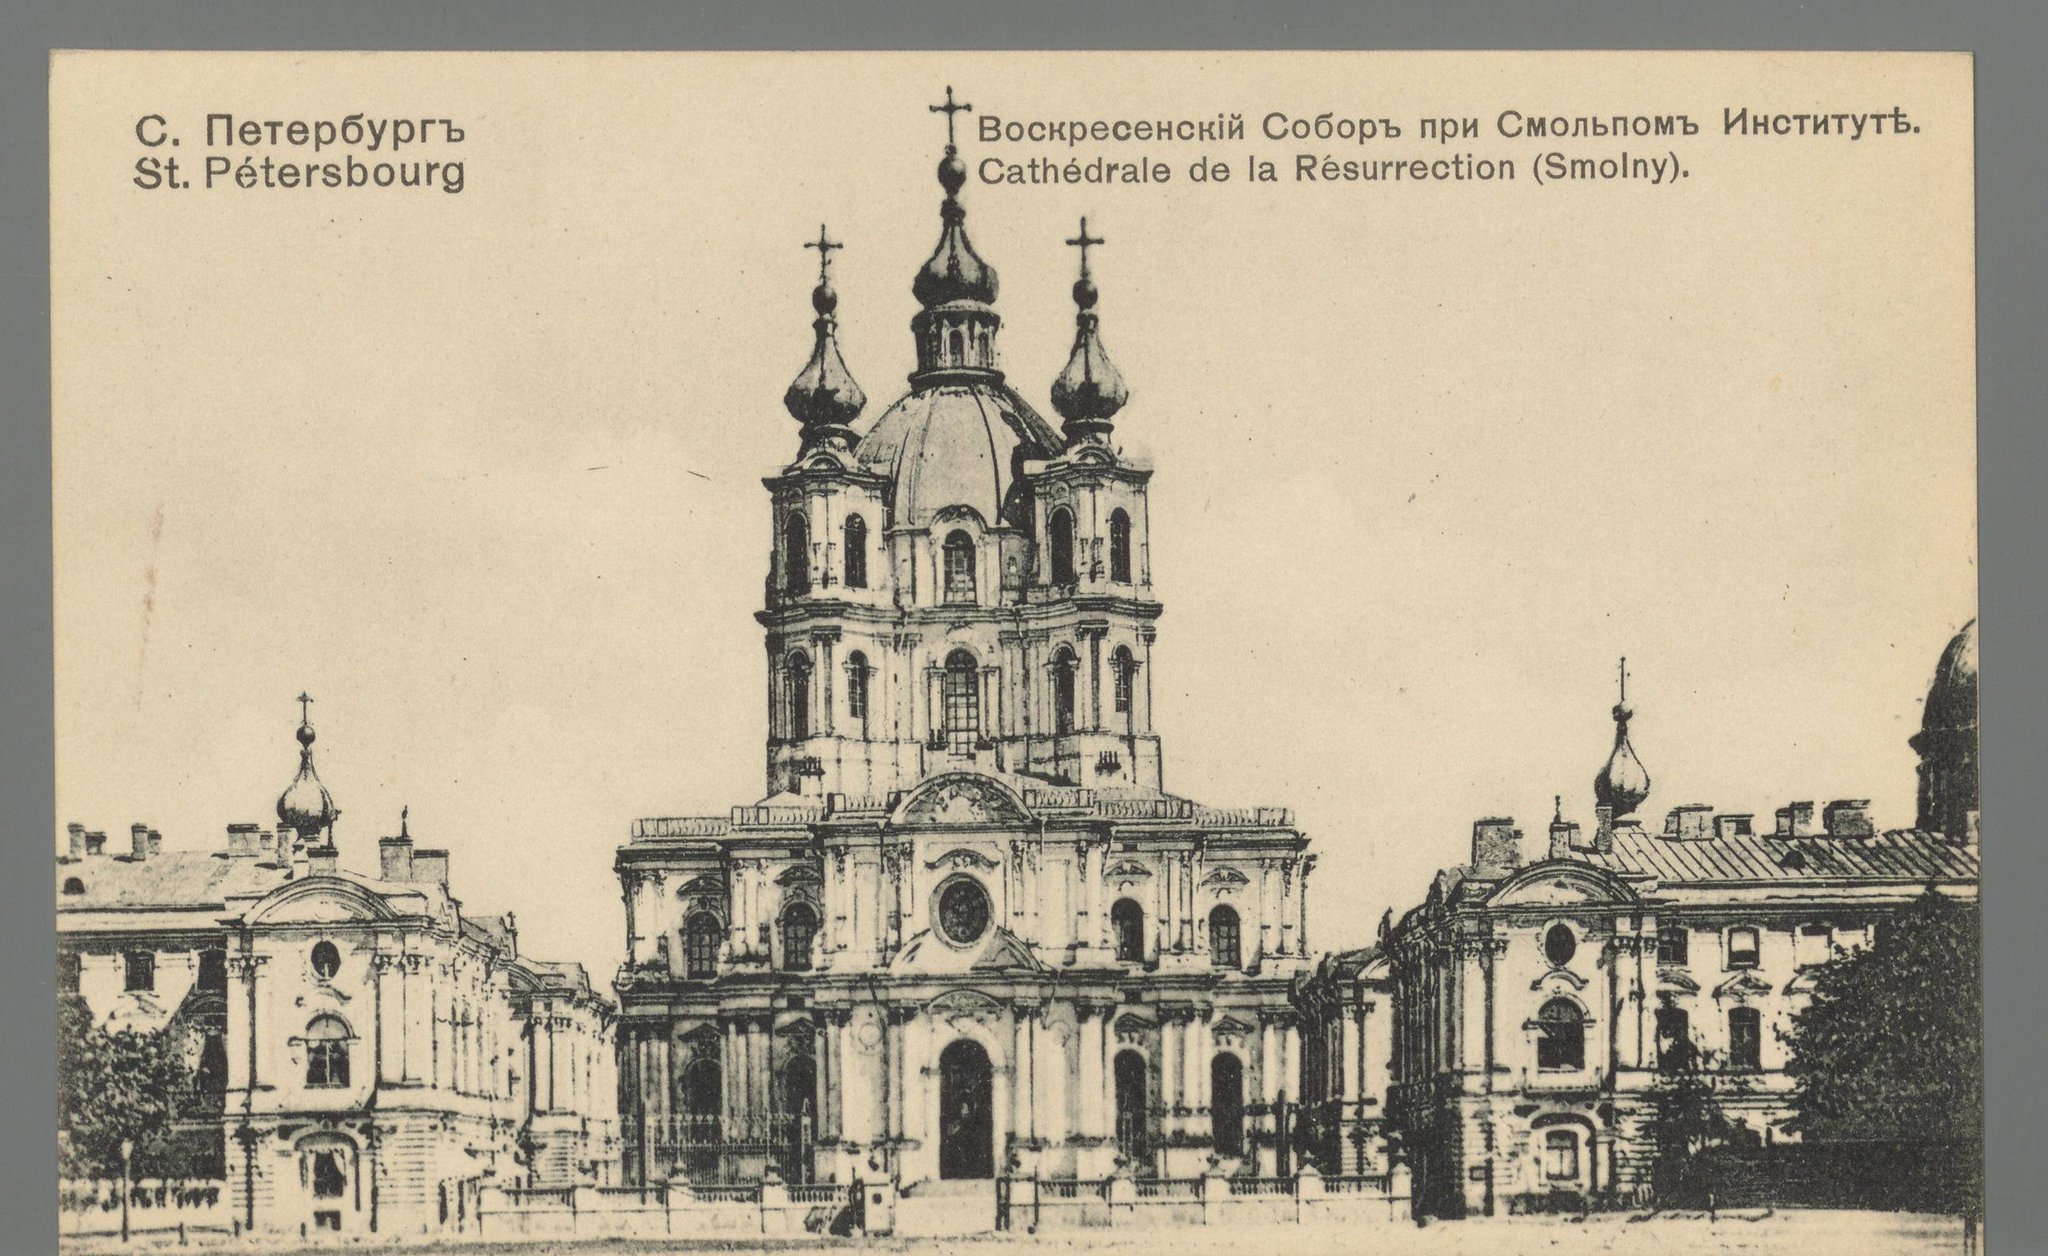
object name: ansichtkaart, prentbriefkaart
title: St. Pétersbourg. Cathédrale de la Résurrection (Smolny)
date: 1904-1930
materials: cardboard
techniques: photograph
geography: sint-petersburg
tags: abbey, monastery, convent ~ roman catholic church, church (exterior)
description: Boven de Franse titel staat de titel in het Russisch.